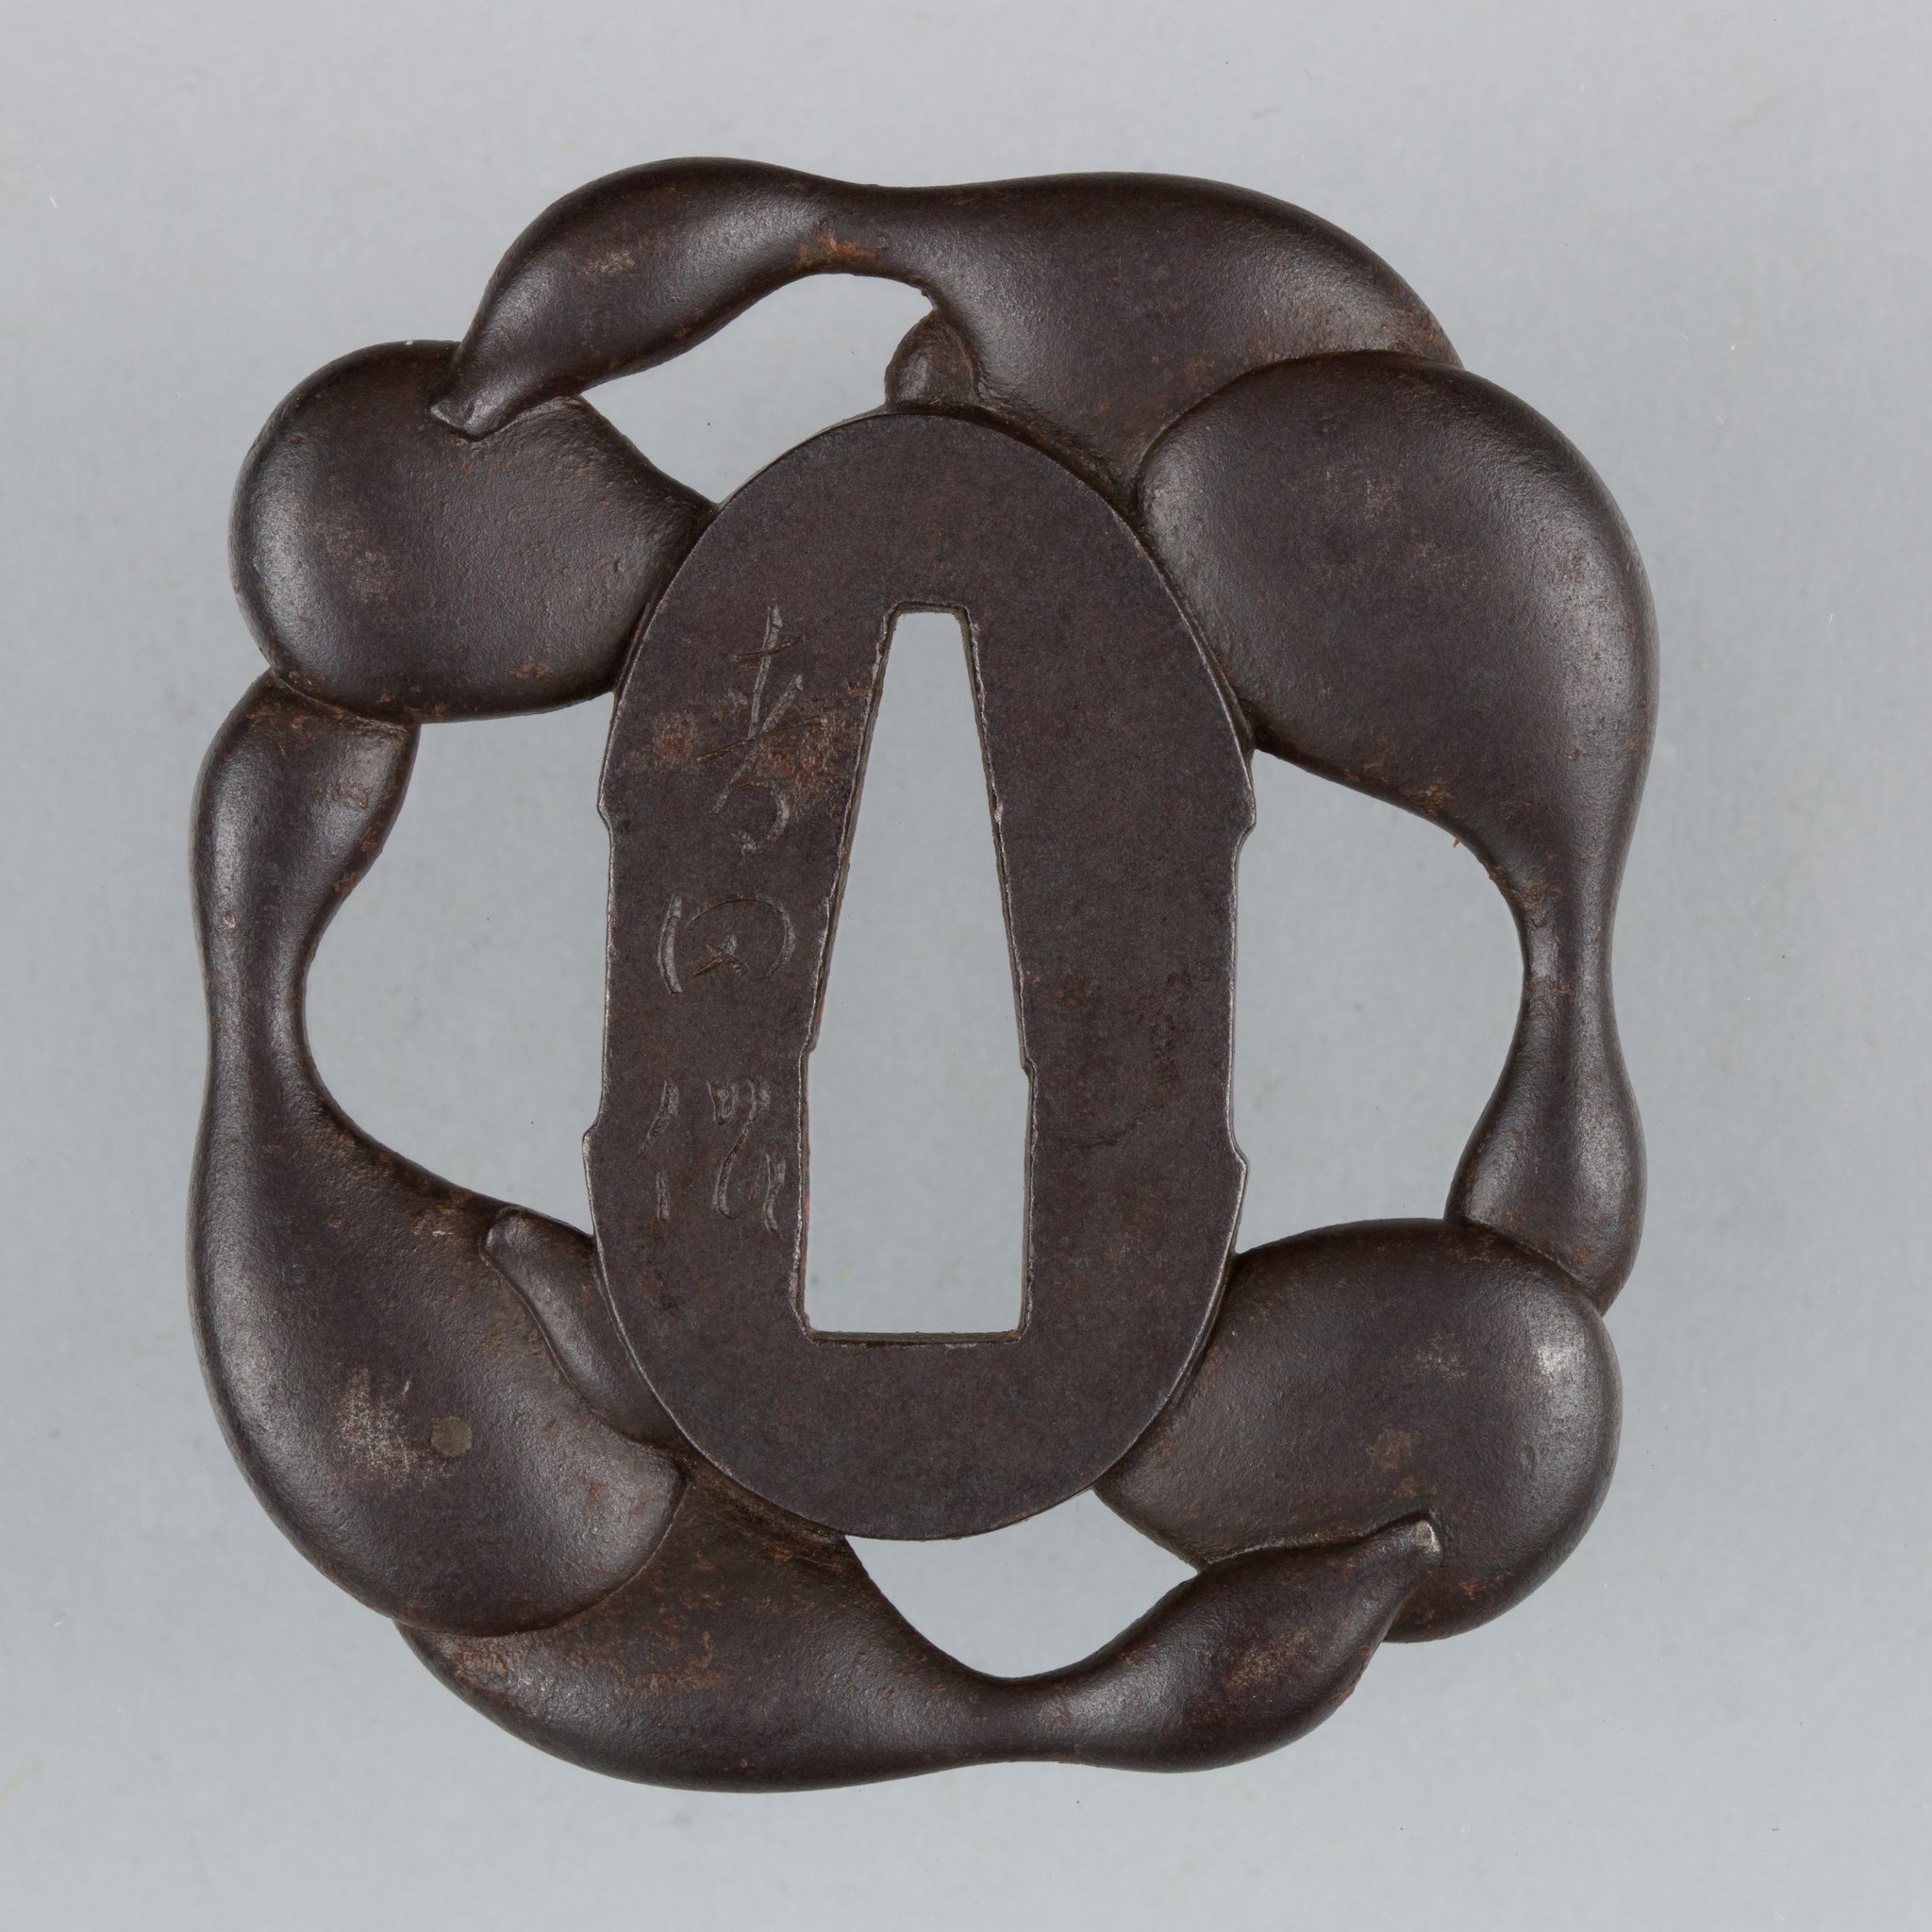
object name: sword guard tsuba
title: Sword Guard (Tsuba)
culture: japanese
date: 1701-1800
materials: copper, iron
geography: japan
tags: gourds